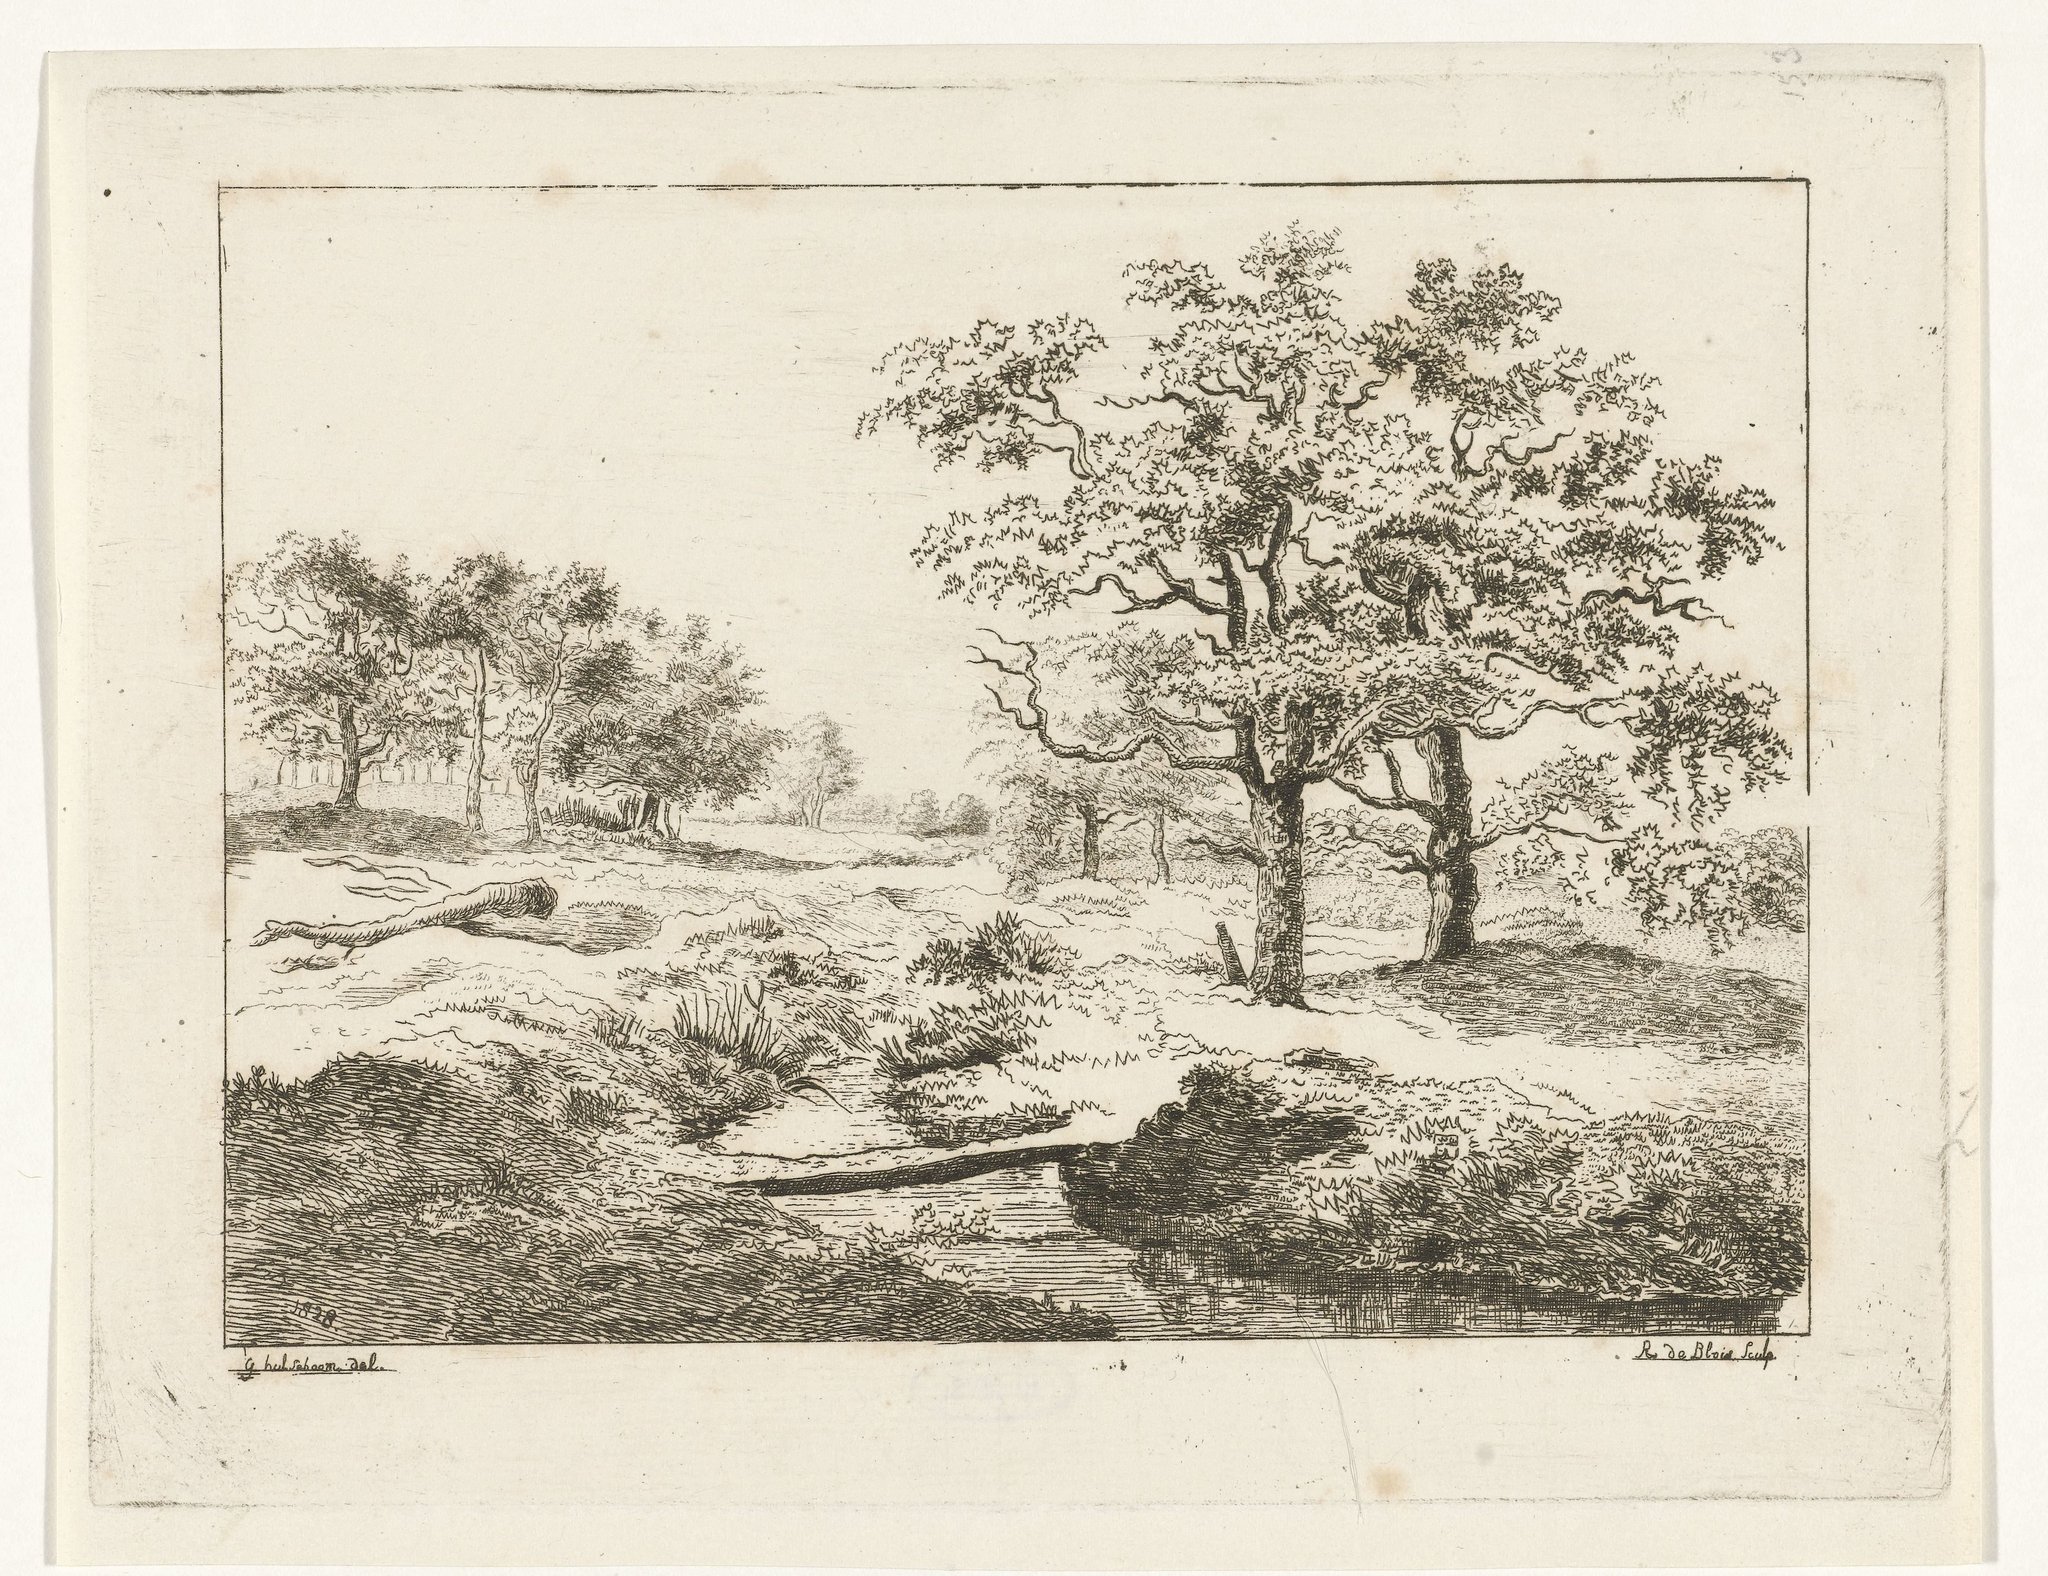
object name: print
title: Beek met vonder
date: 1828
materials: paper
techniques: engraving, etching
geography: vaassen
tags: trees, brook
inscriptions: collector's mark: Lugt 2228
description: Een vonder, een houten balk, over een beekje. Rechts twee bomen.